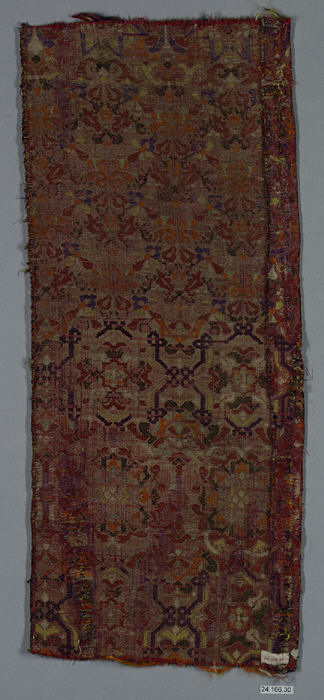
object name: belt or sash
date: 1701-1800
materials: silk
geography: morocco